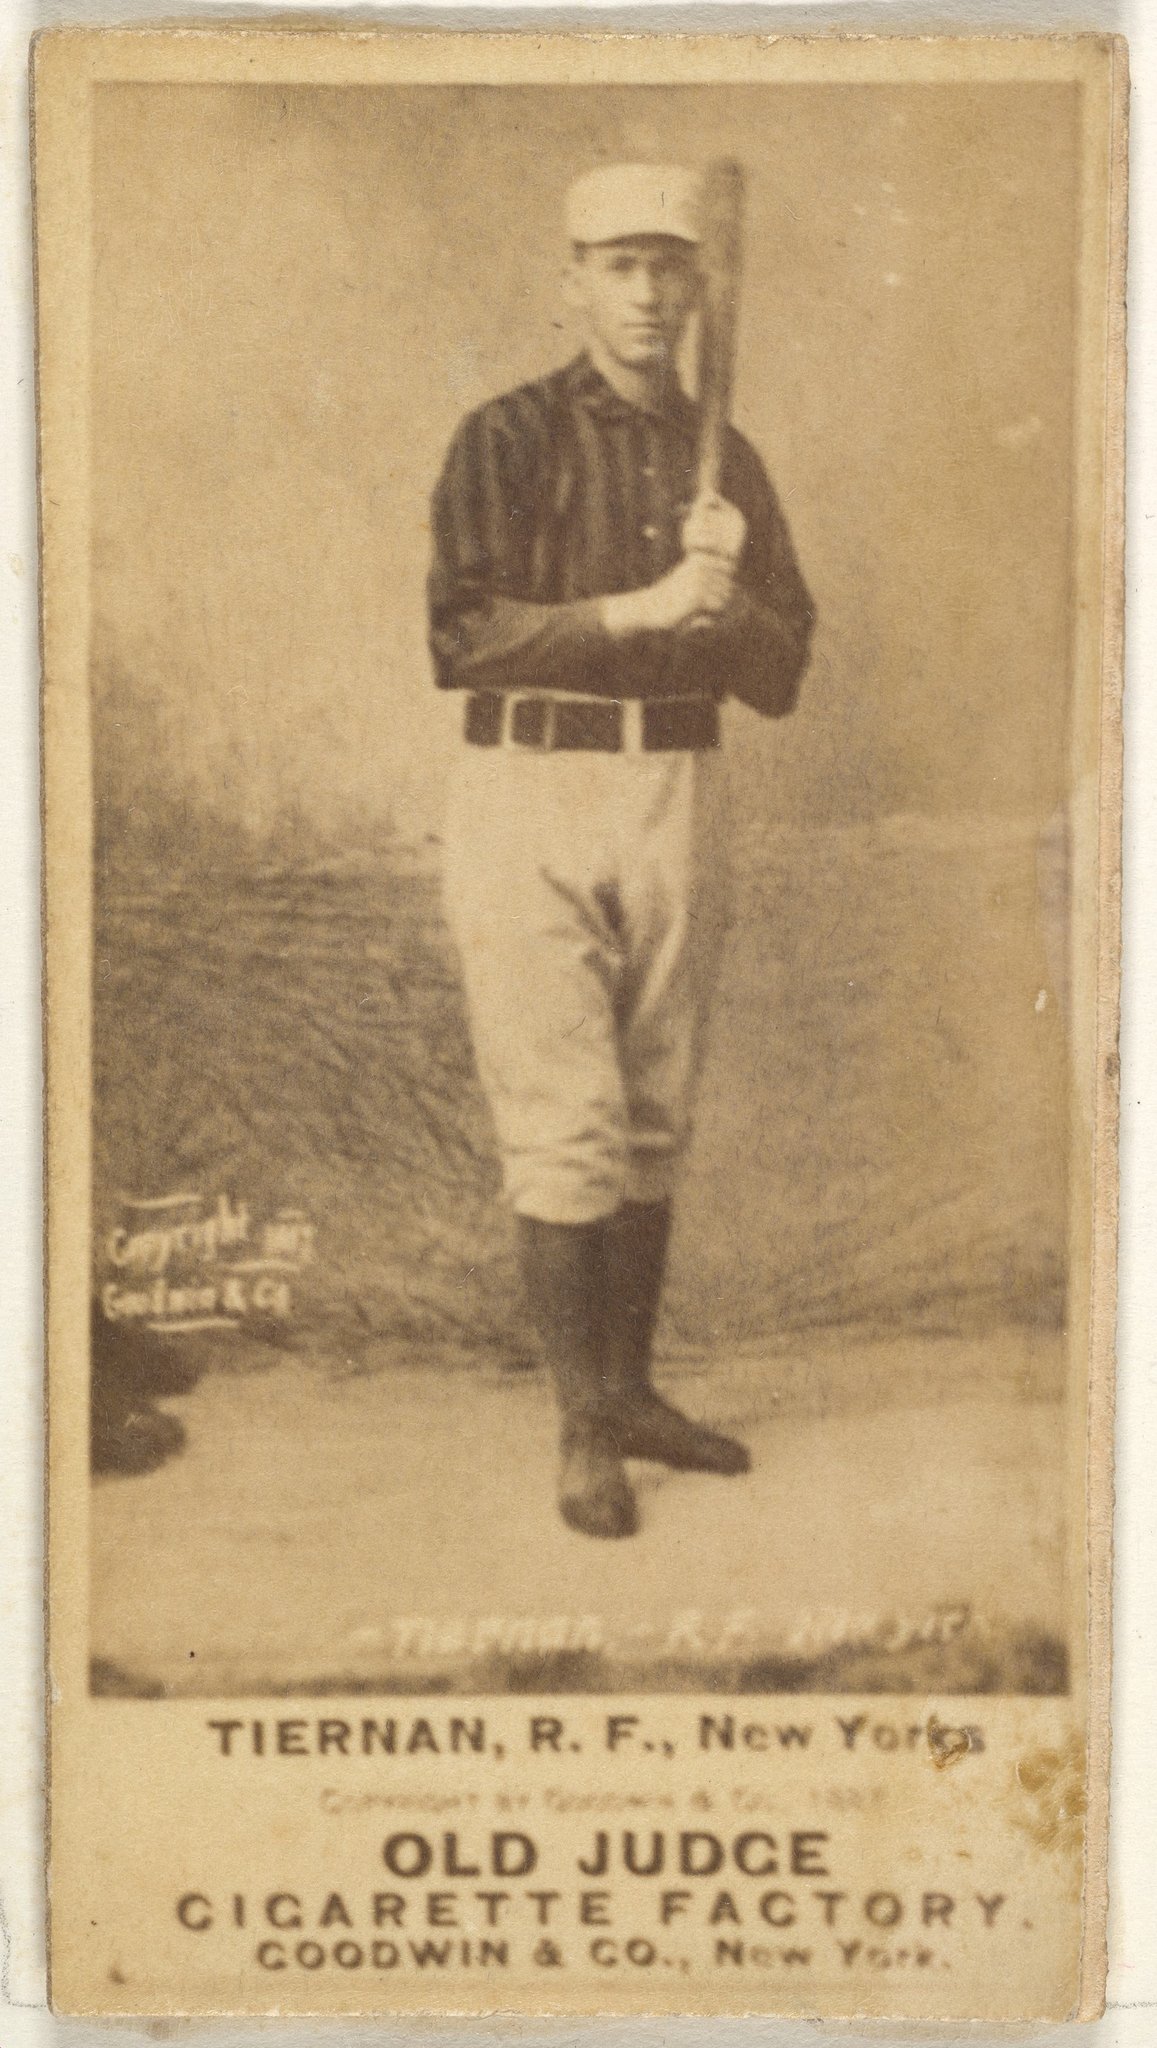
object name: baseball card, photograph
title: Michael "Silent Mike" Joseph Tiernan, Right Field, New York, from the Old Judge series (N172) for Old Judge Cigarettes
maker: goodwin & company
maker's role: publisher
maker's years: 1850-1950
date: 1887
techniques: albumen silver print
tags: men,portraits,baseball,athletes